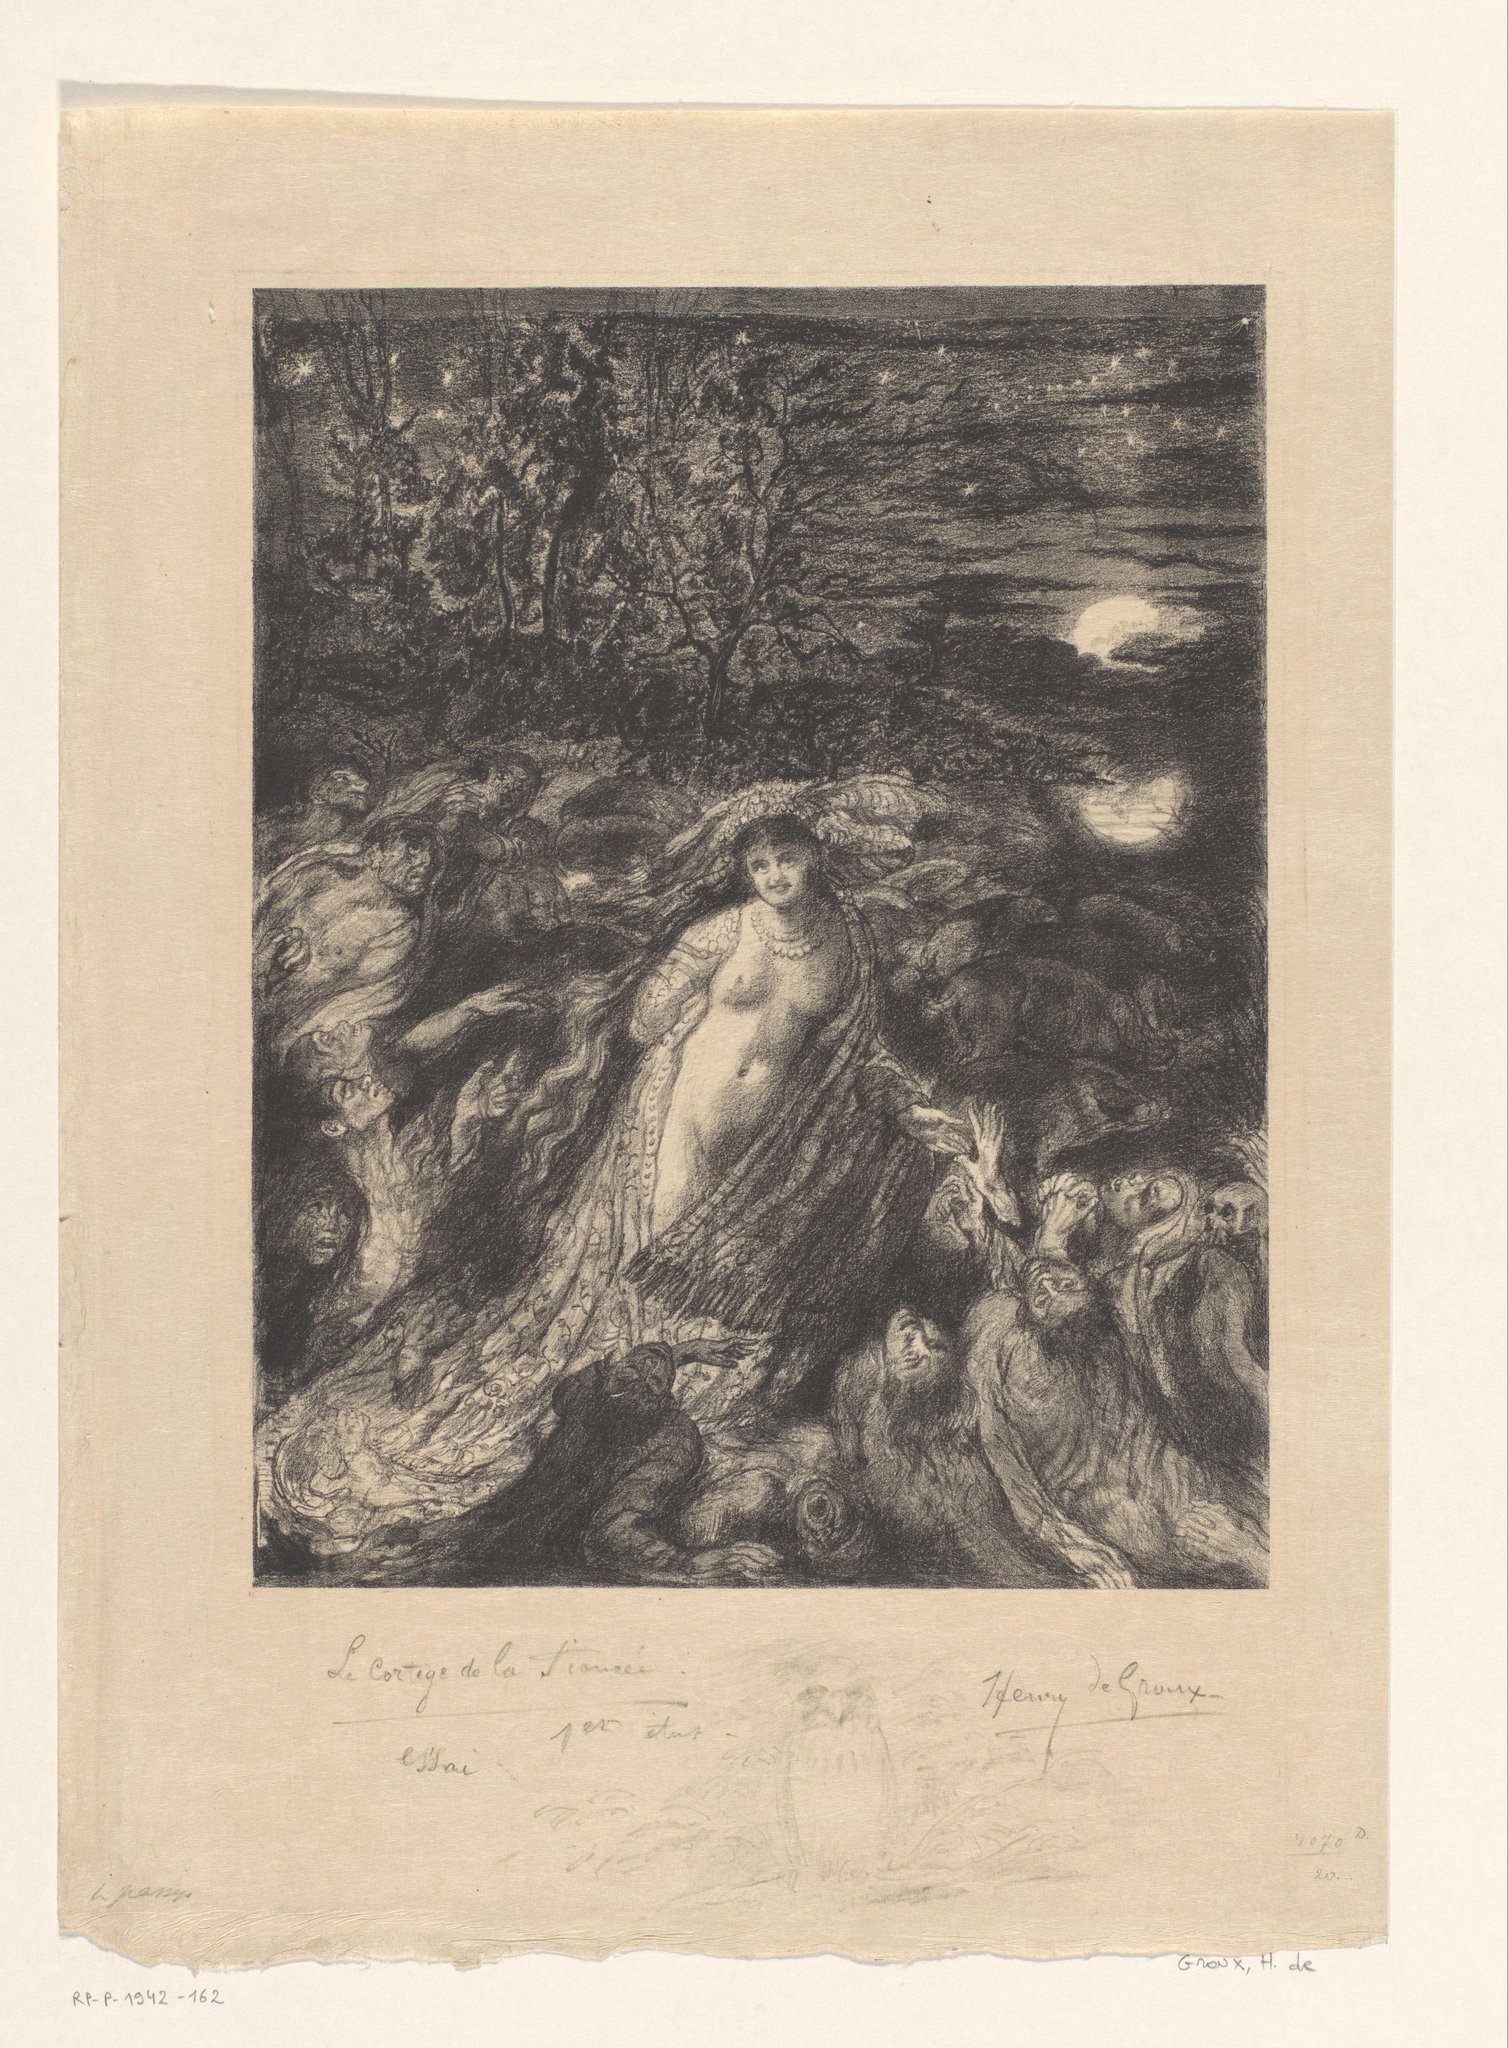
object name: print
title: Half naakte vrouw aanbeden door een groep figuren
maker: henri de groux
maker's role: painter, print maker, sculptor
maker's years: 1866-1930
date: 1894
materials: paper, pencil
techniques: lithograph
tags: pig, woman (showing herself) undressed, quasi-nude, bride (in wedding-dress), night, moon as celestial body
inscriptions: inscription: ‘Essai, 1er etat’, collector's mark: Lugt 2760, collector's mark: Lugt 2228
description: Tekening van een uil midden onder in de marge.